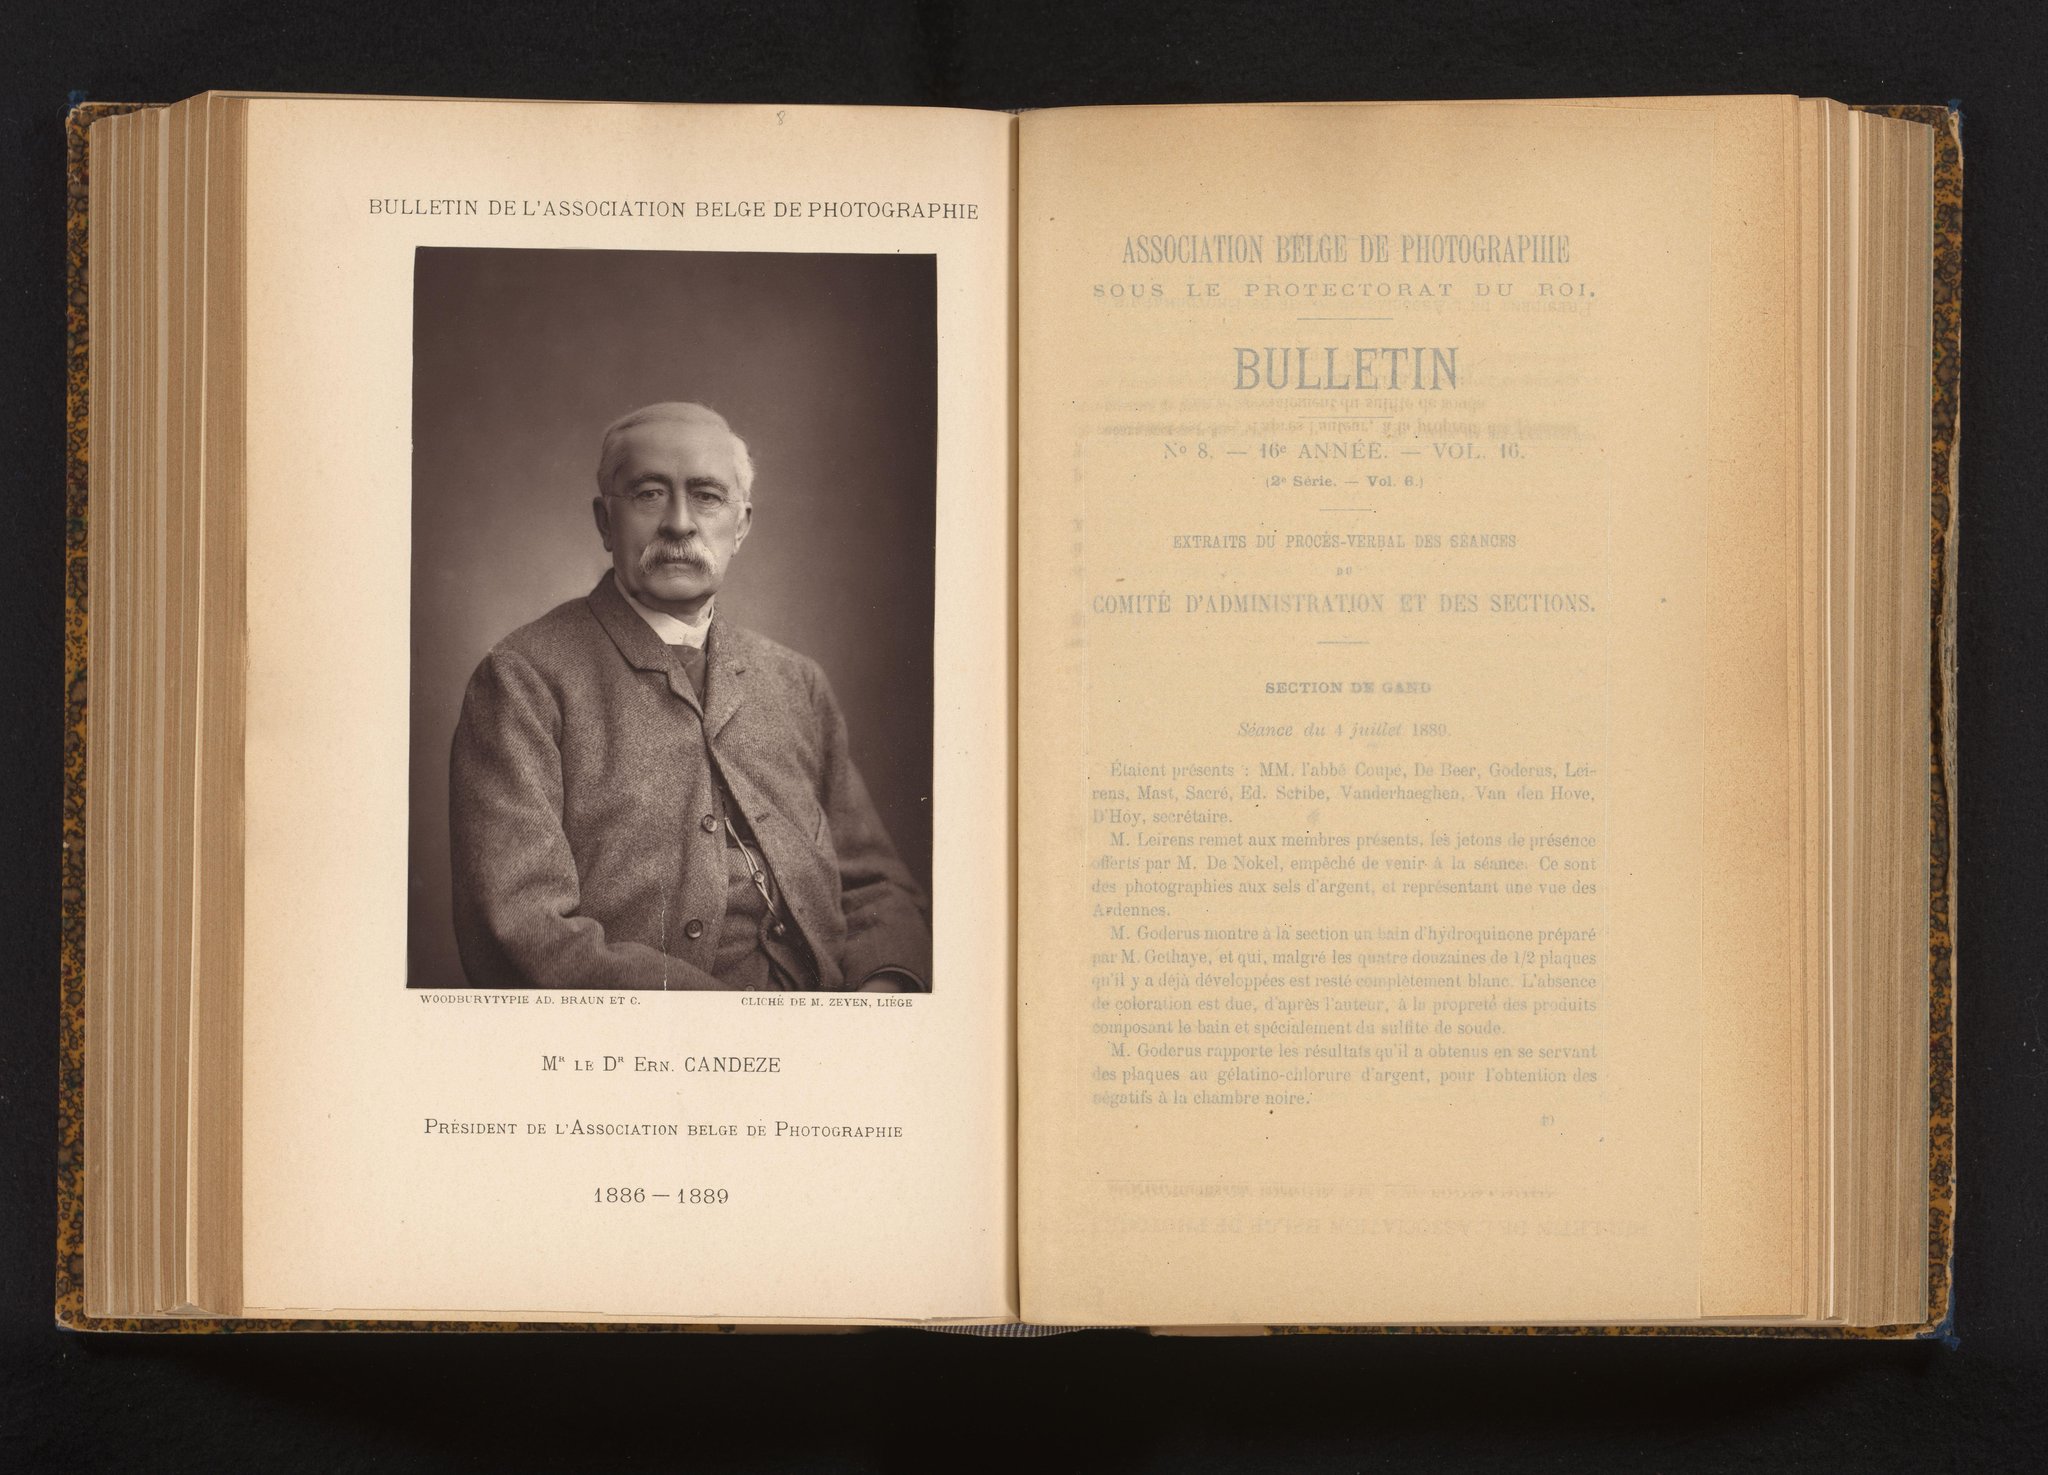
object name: photomechanical print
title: Mr. le Dr. Ern. Candeze. Président de l'Association Belge de Photographie (1886-1889)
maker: léonard hubert zeyen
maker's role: fotograaf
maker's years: 1840-1907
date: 1886-1889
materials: paper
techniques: woodburytype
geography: dornach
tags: chairman, adult man, historical persons